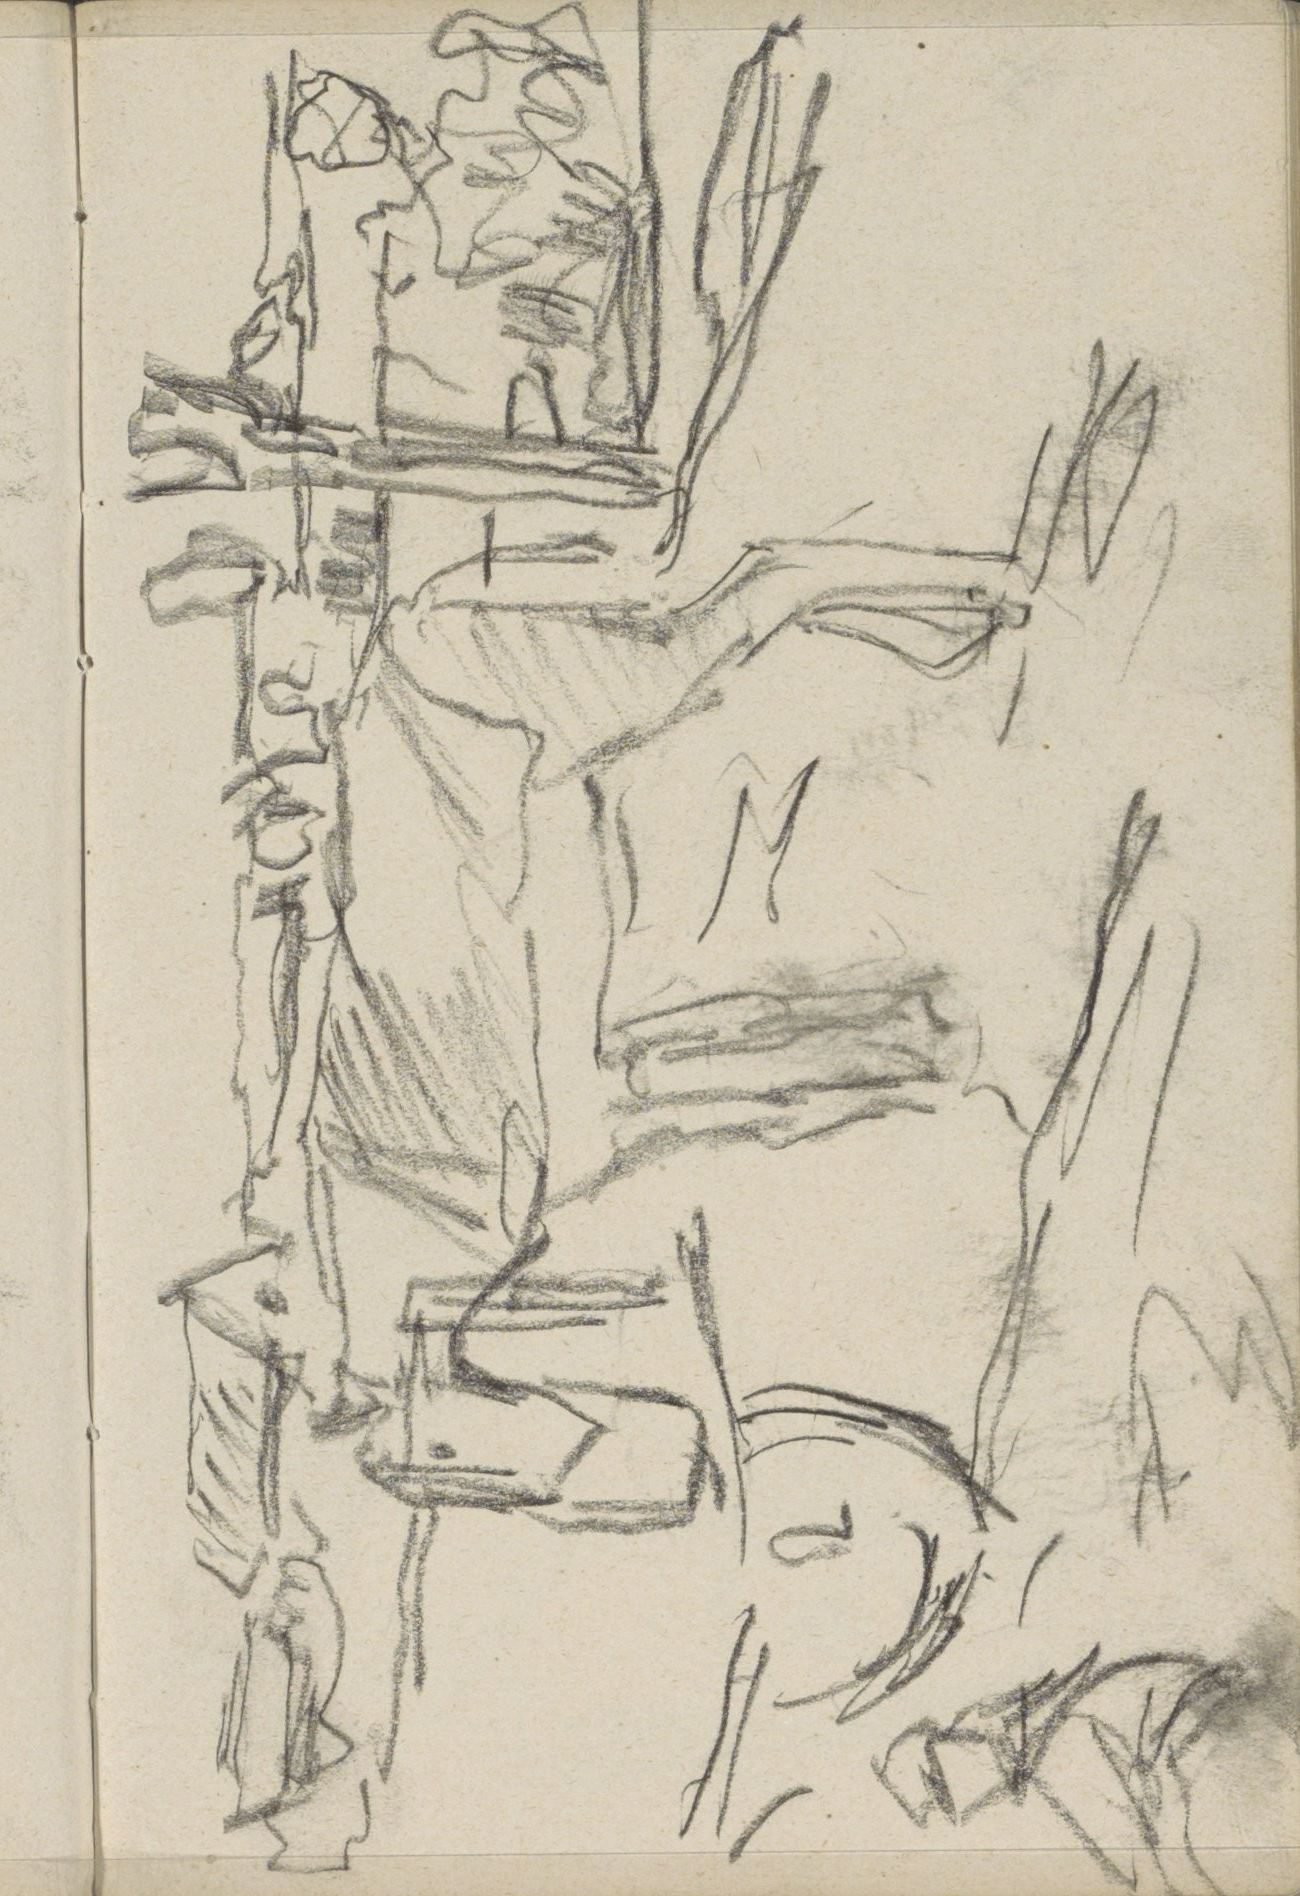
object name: sketchbook leaf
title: Uitgespannen paard met een haverzak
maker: george hendrik breitner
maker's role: draughtsman, painter, print maker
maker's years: 1857-1923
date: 1914-1923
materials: chalk, paper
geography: amsterdam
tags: horse, (farm) wagon, freight wagon, cart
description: Achter een kar staat een uitgespannen paard met een haverzak. Vooraan en achteraan figuren. In de verte gebouwen. Pagina 52 uit een schetsboek met 43 bladen vervaardigd te Amsterdam.